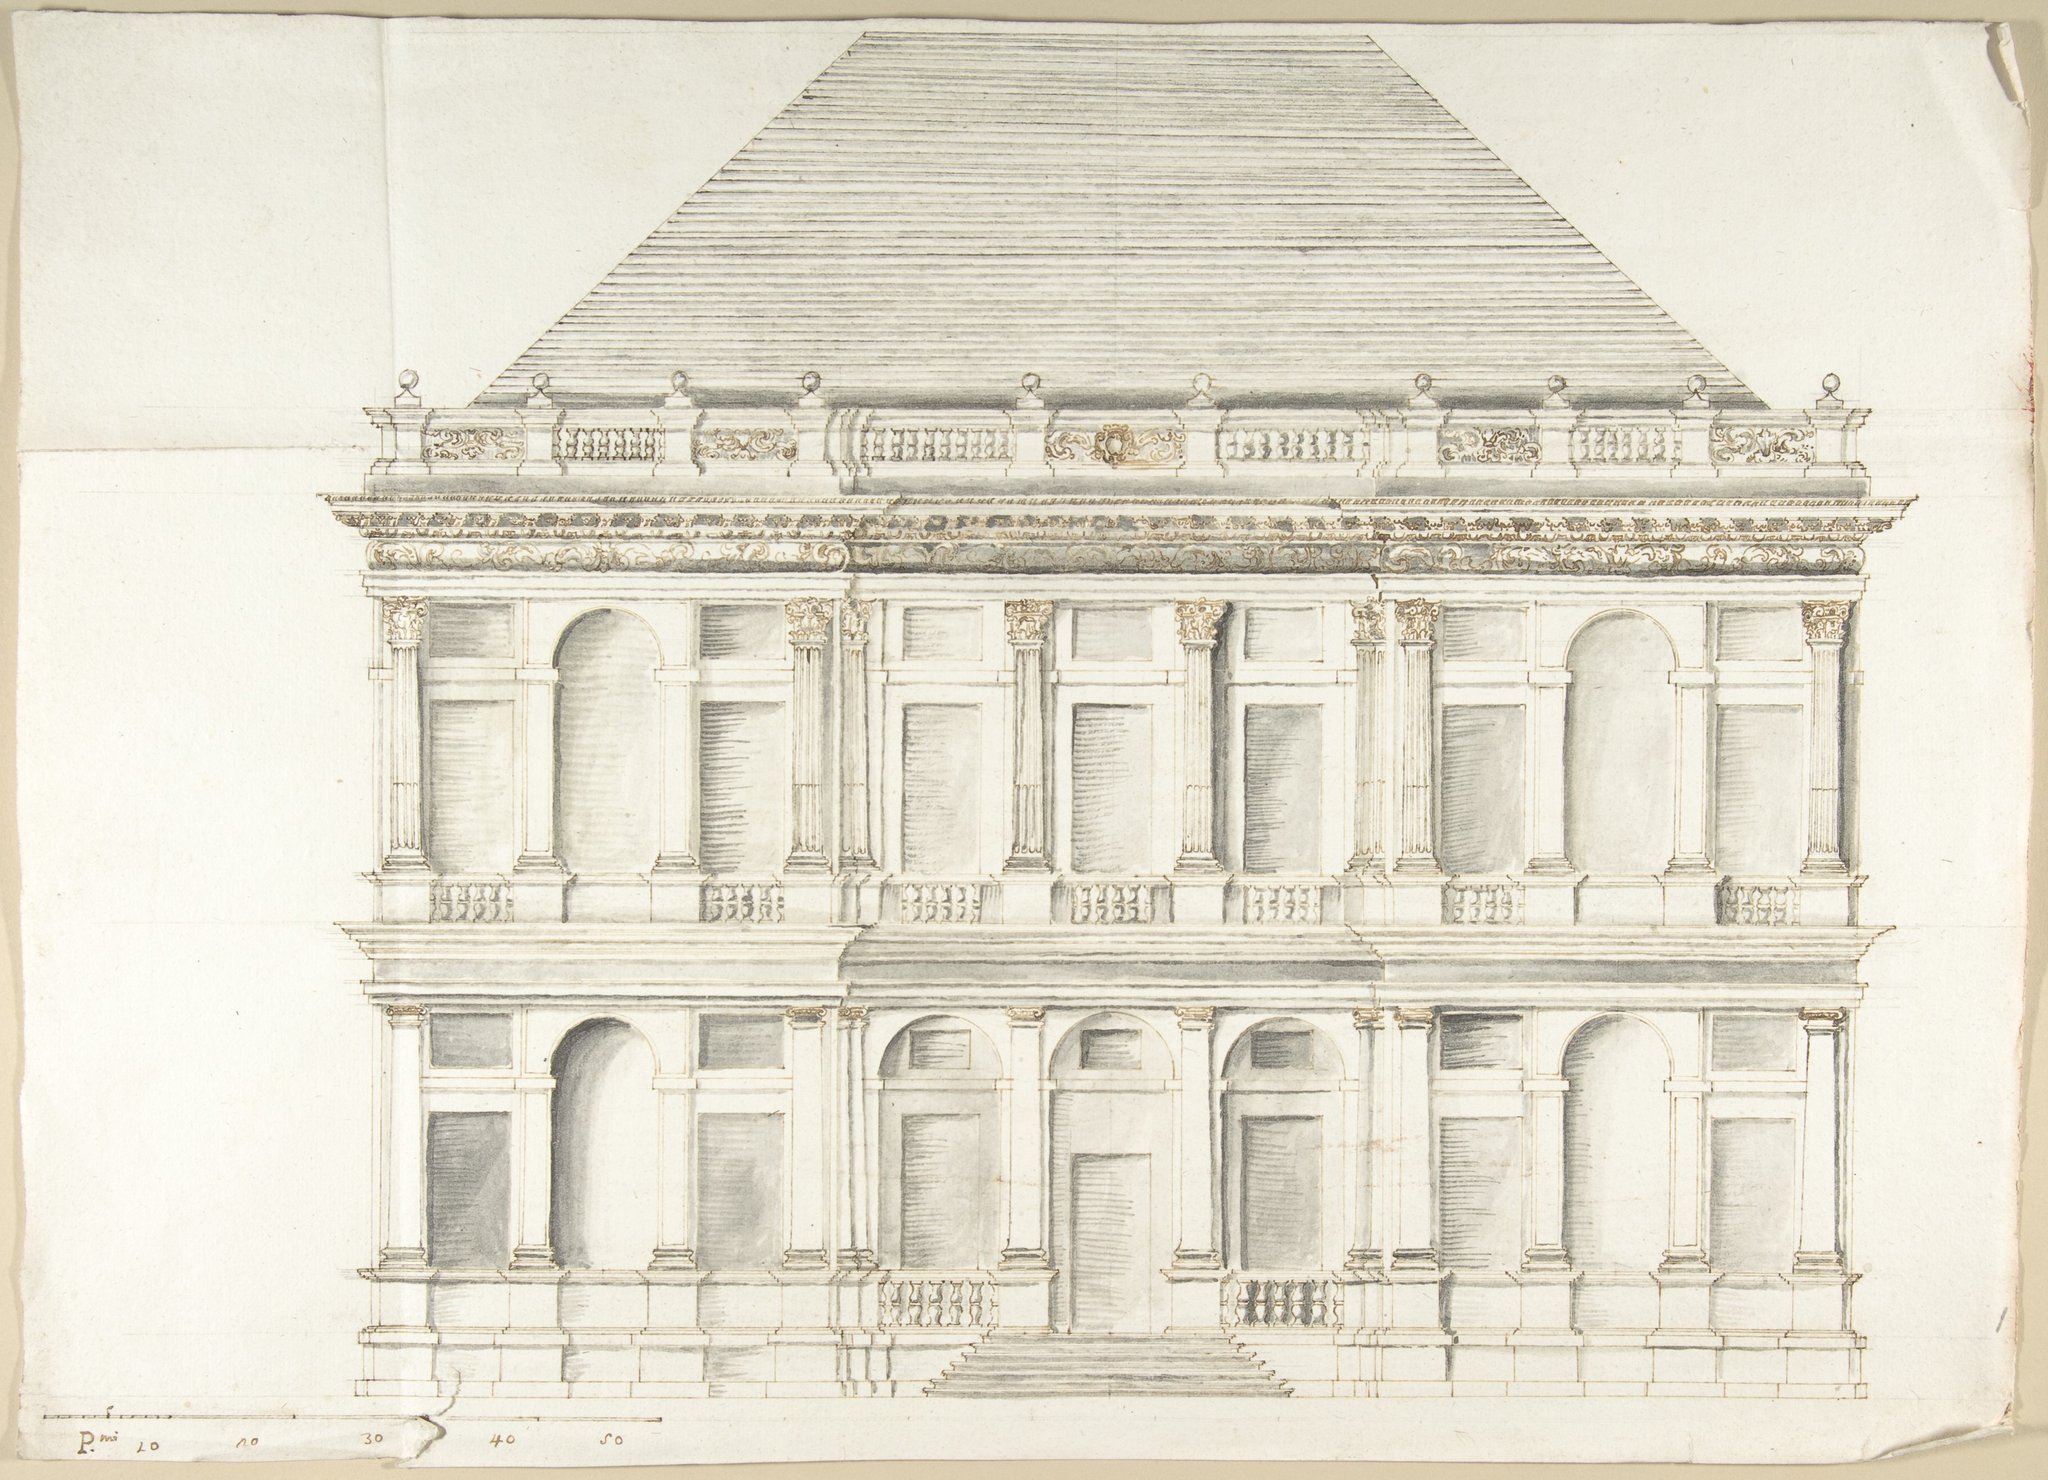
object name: drawing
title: Two-Story Façade of a Palace with a Mansard Roof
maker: pietro paolo coccetti (cocchetti)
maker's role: artist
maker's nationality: italian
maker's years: 1710-1727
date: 1710-1727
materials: graphite, ink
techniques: brush, pen, wash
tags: architecture,palaces